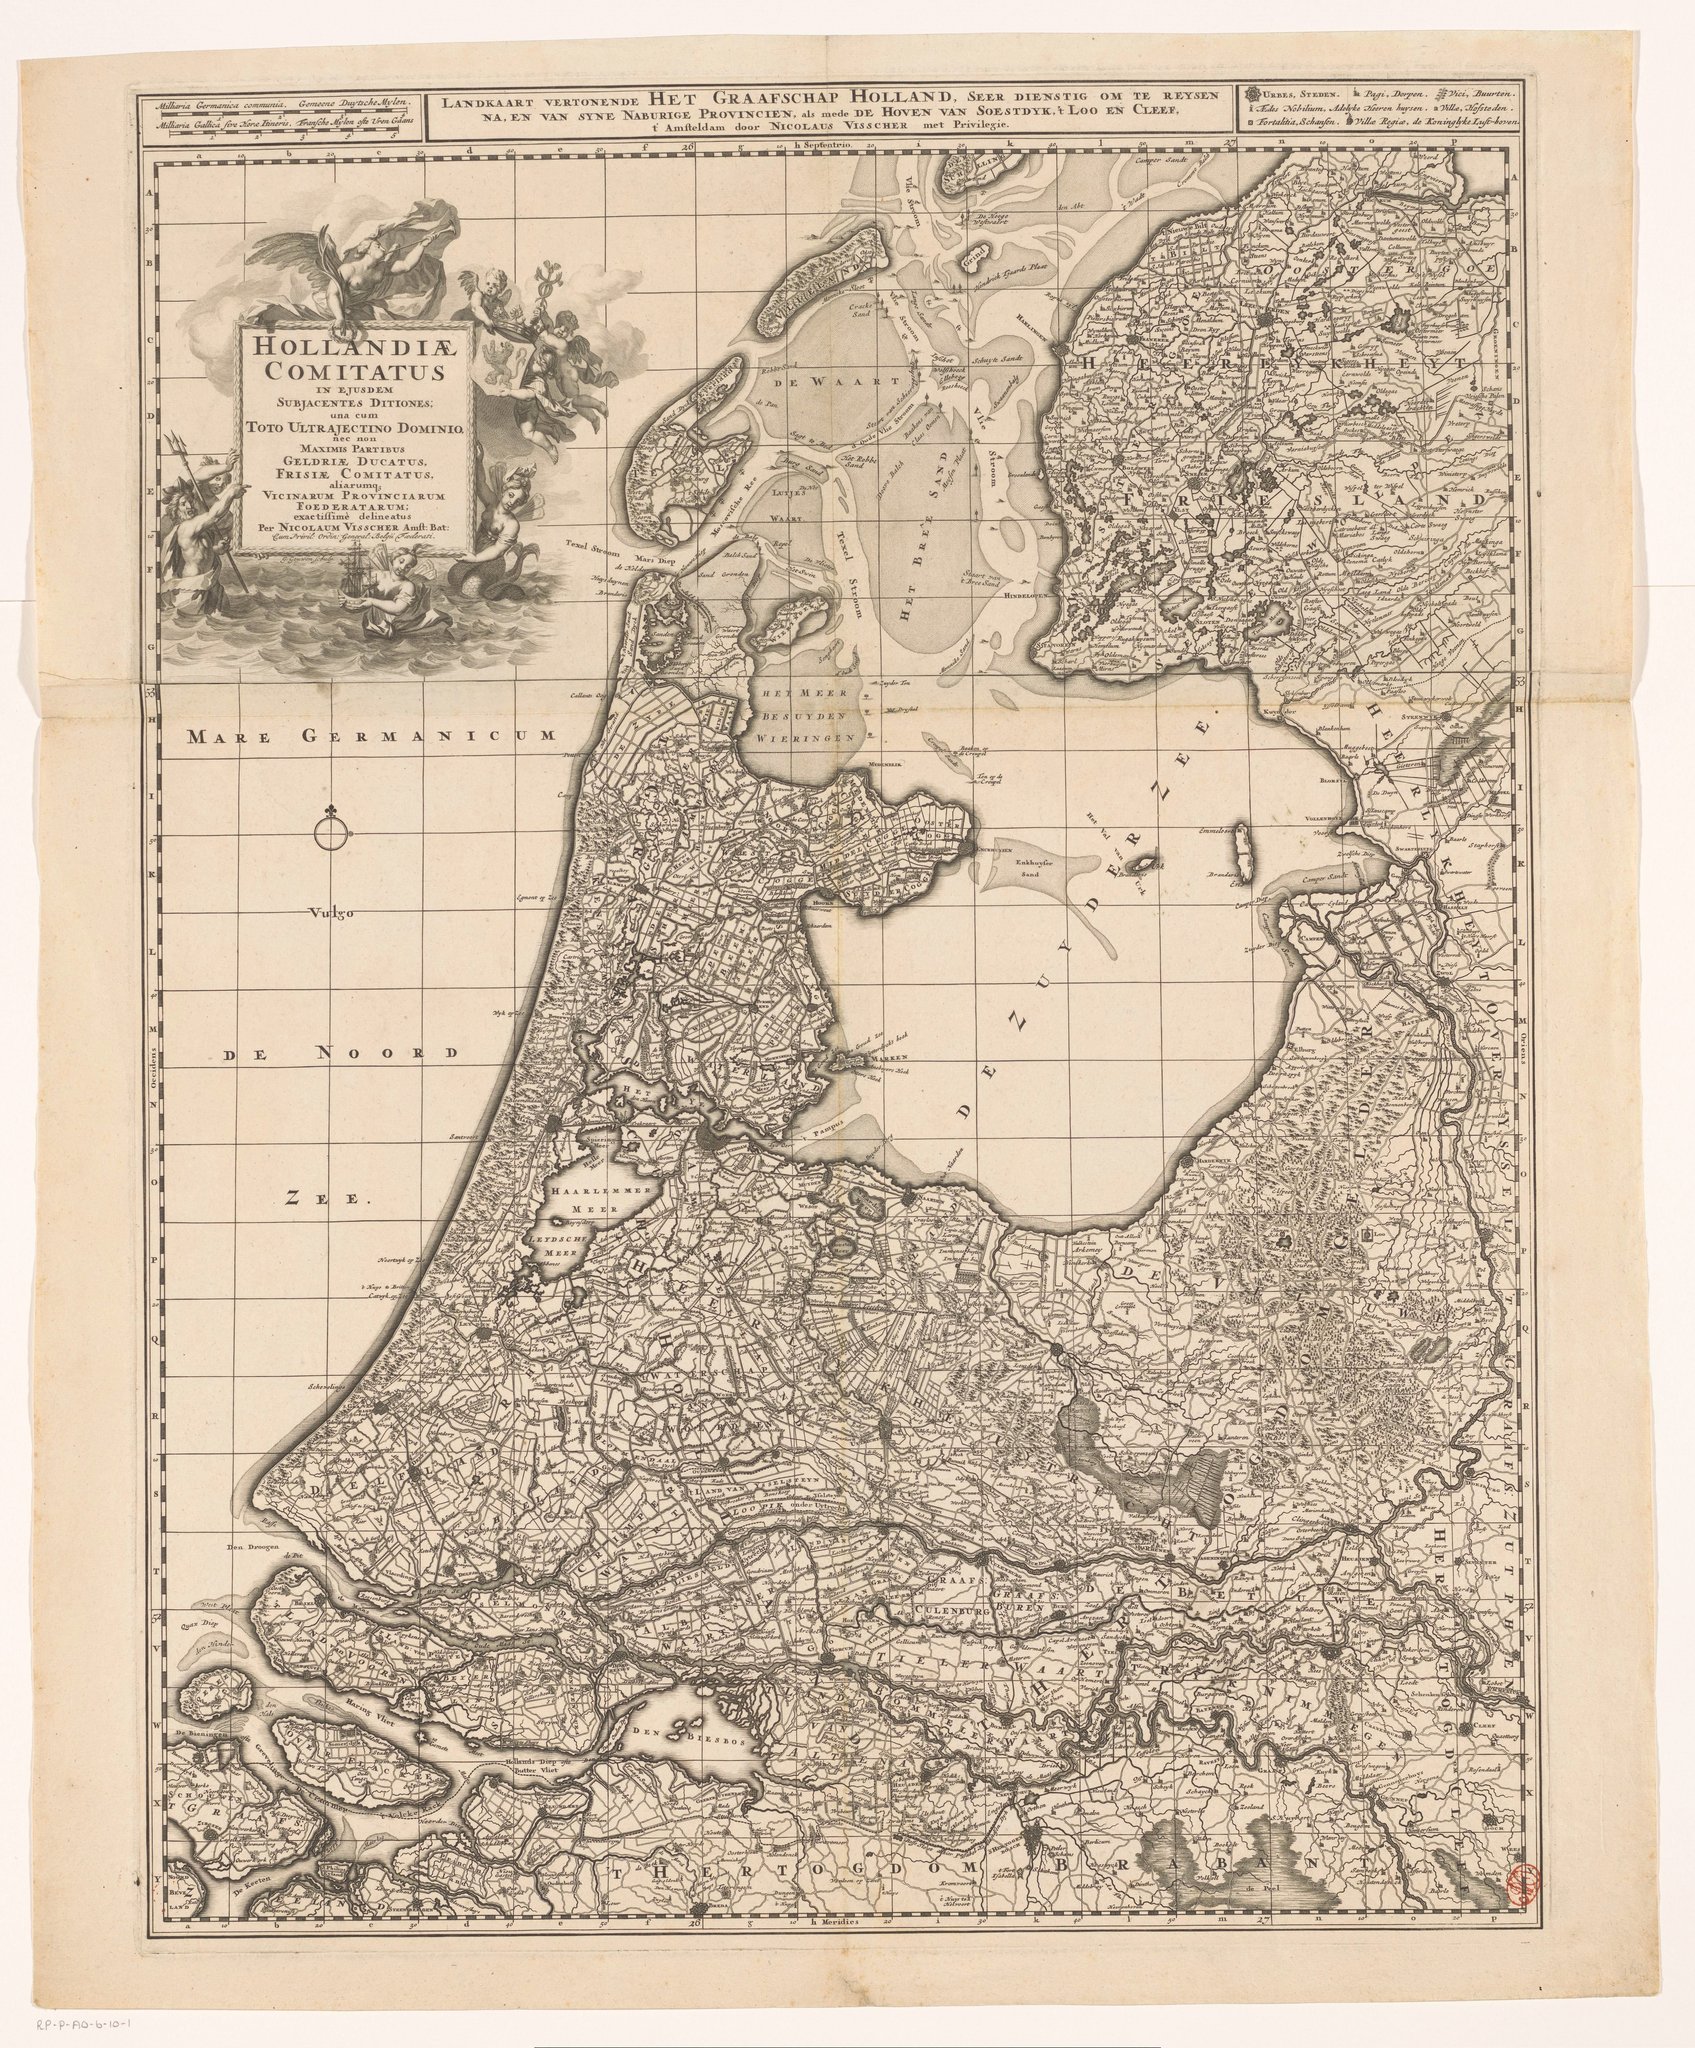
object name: map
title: Landkaart vertonende het graafschap Holland, seer dienstig om te reysen na, en van syne naburige provincien … / Hollandiae Comitatus in ejusdem subjacentes ditiones …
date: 1690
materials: paper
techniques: engraving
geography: amsterdam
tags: (story of) neptune (poseidon), coat of arms (as symbol of the state, etc.), maps of separate countries or regions, merman - aa - mermaid, siren, fame; 'fama', 'fama buona', 'fama chiara' (ripa), holland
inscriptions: collector's mark: Lugt 195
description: Kaart van het graafschap Holland en omliggende gebieden. Helemaal boven in het midden de Nederlandse titel. Links daarvan twee schaalstokken: Milliaria Germanica communia / Gemeene Duytsche mylen; Milliaria Gallica sive horae itineris / Fransche mylen ofte uren gaens. Rechts van die titel de legenda. Linksboven op de kaart een cartouche met de Latijnse titel. Daaromheen Fama, putti met het wapen van het graafschap Holland, zeemeerminnen en Neptunus. De kaart is voorzien van een zoekrooster en een gradenverdeling langs de randen.